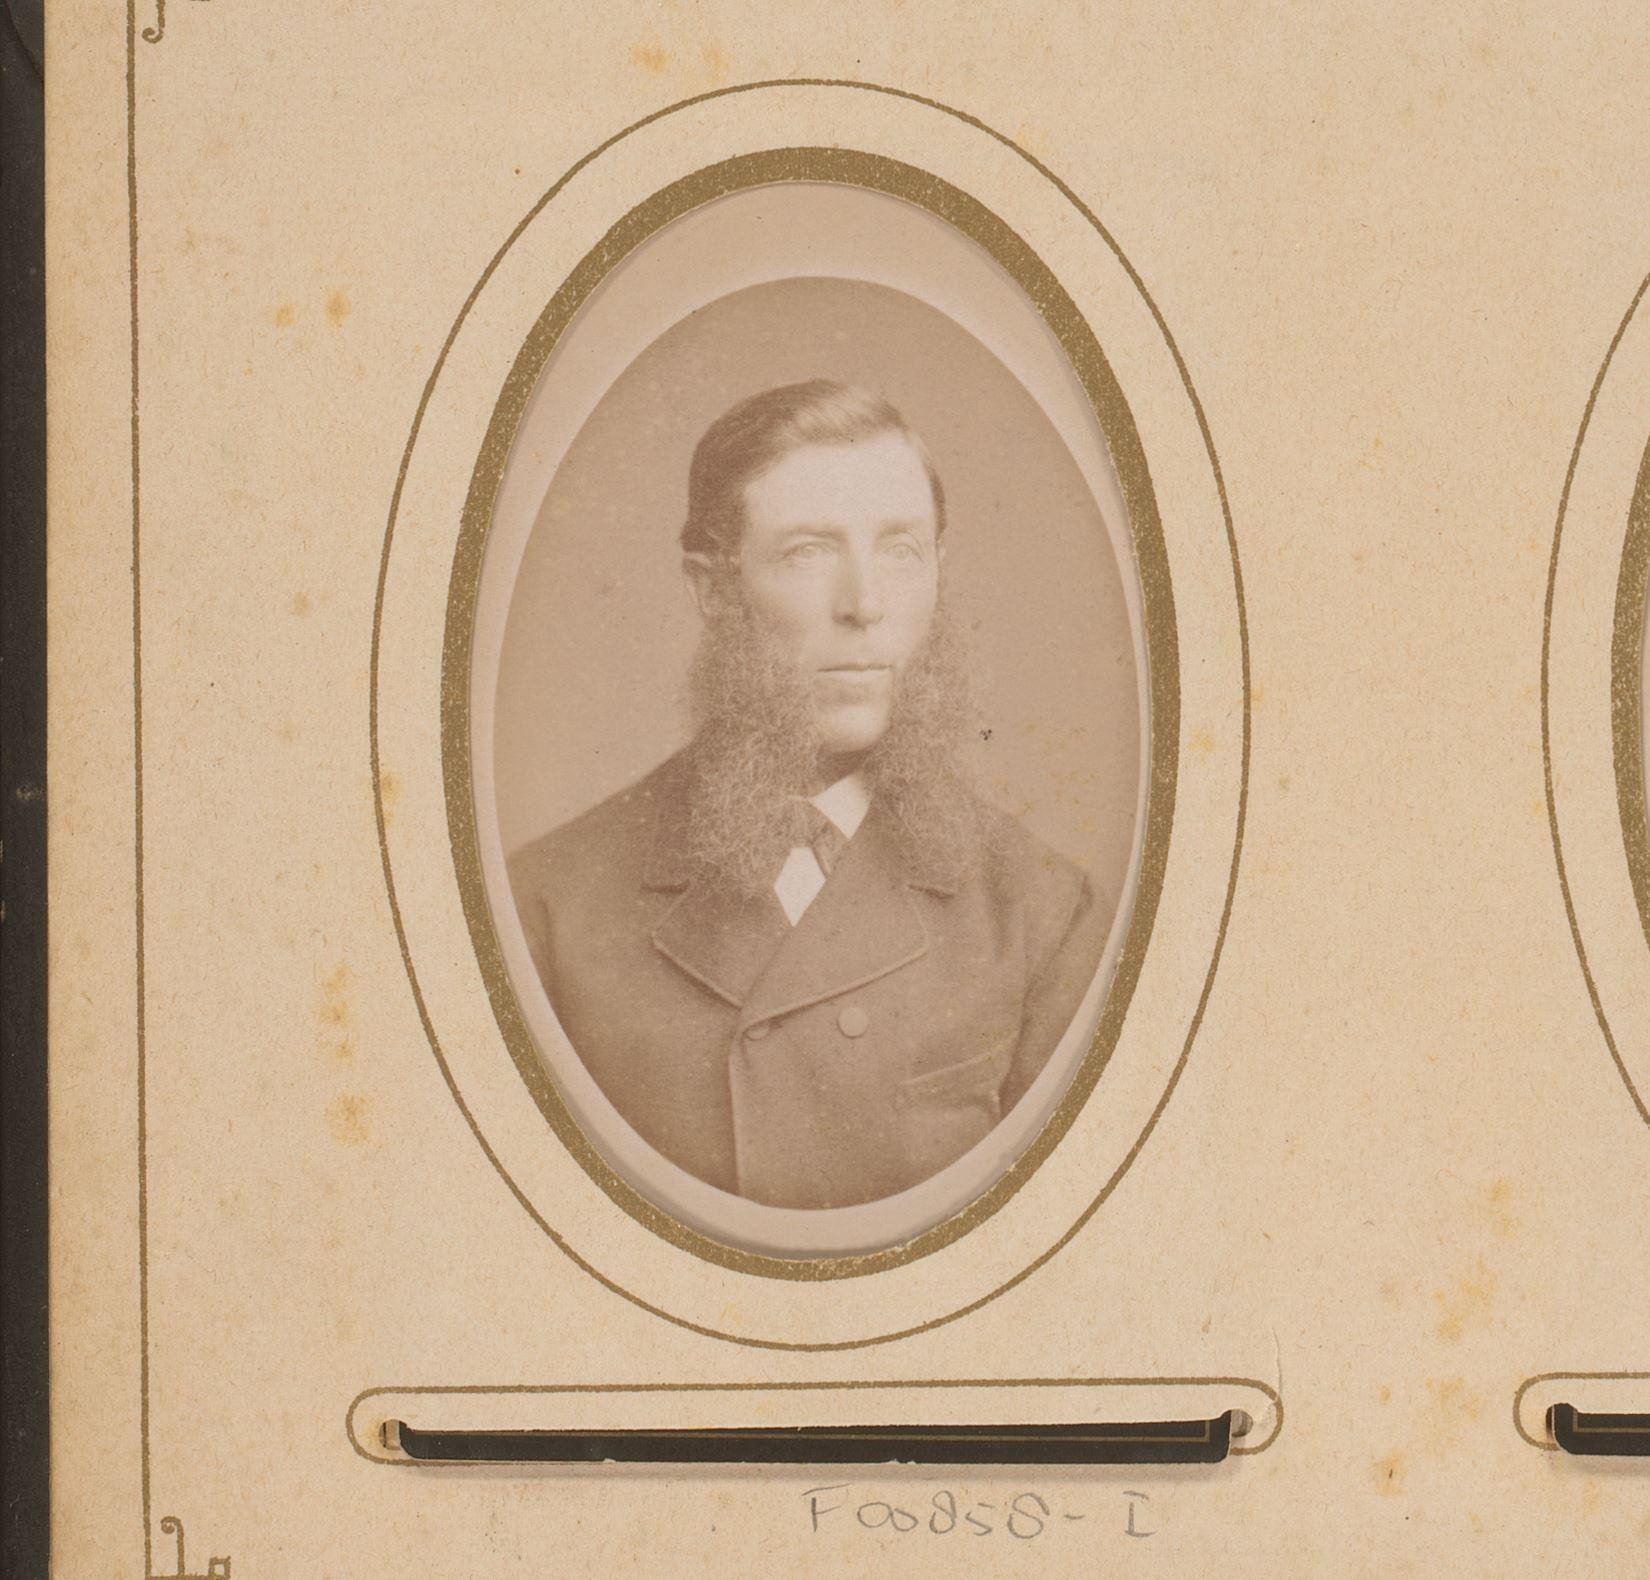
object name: photograph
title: Portret van een man met baard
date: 1884-1895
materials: cardboard, photographic support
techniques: albumen print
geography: alkmaar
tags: historical persons, beard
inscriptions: inscription: ‘Alkmaar, Verdronken Oord; Helder, Kanaalweg 99’